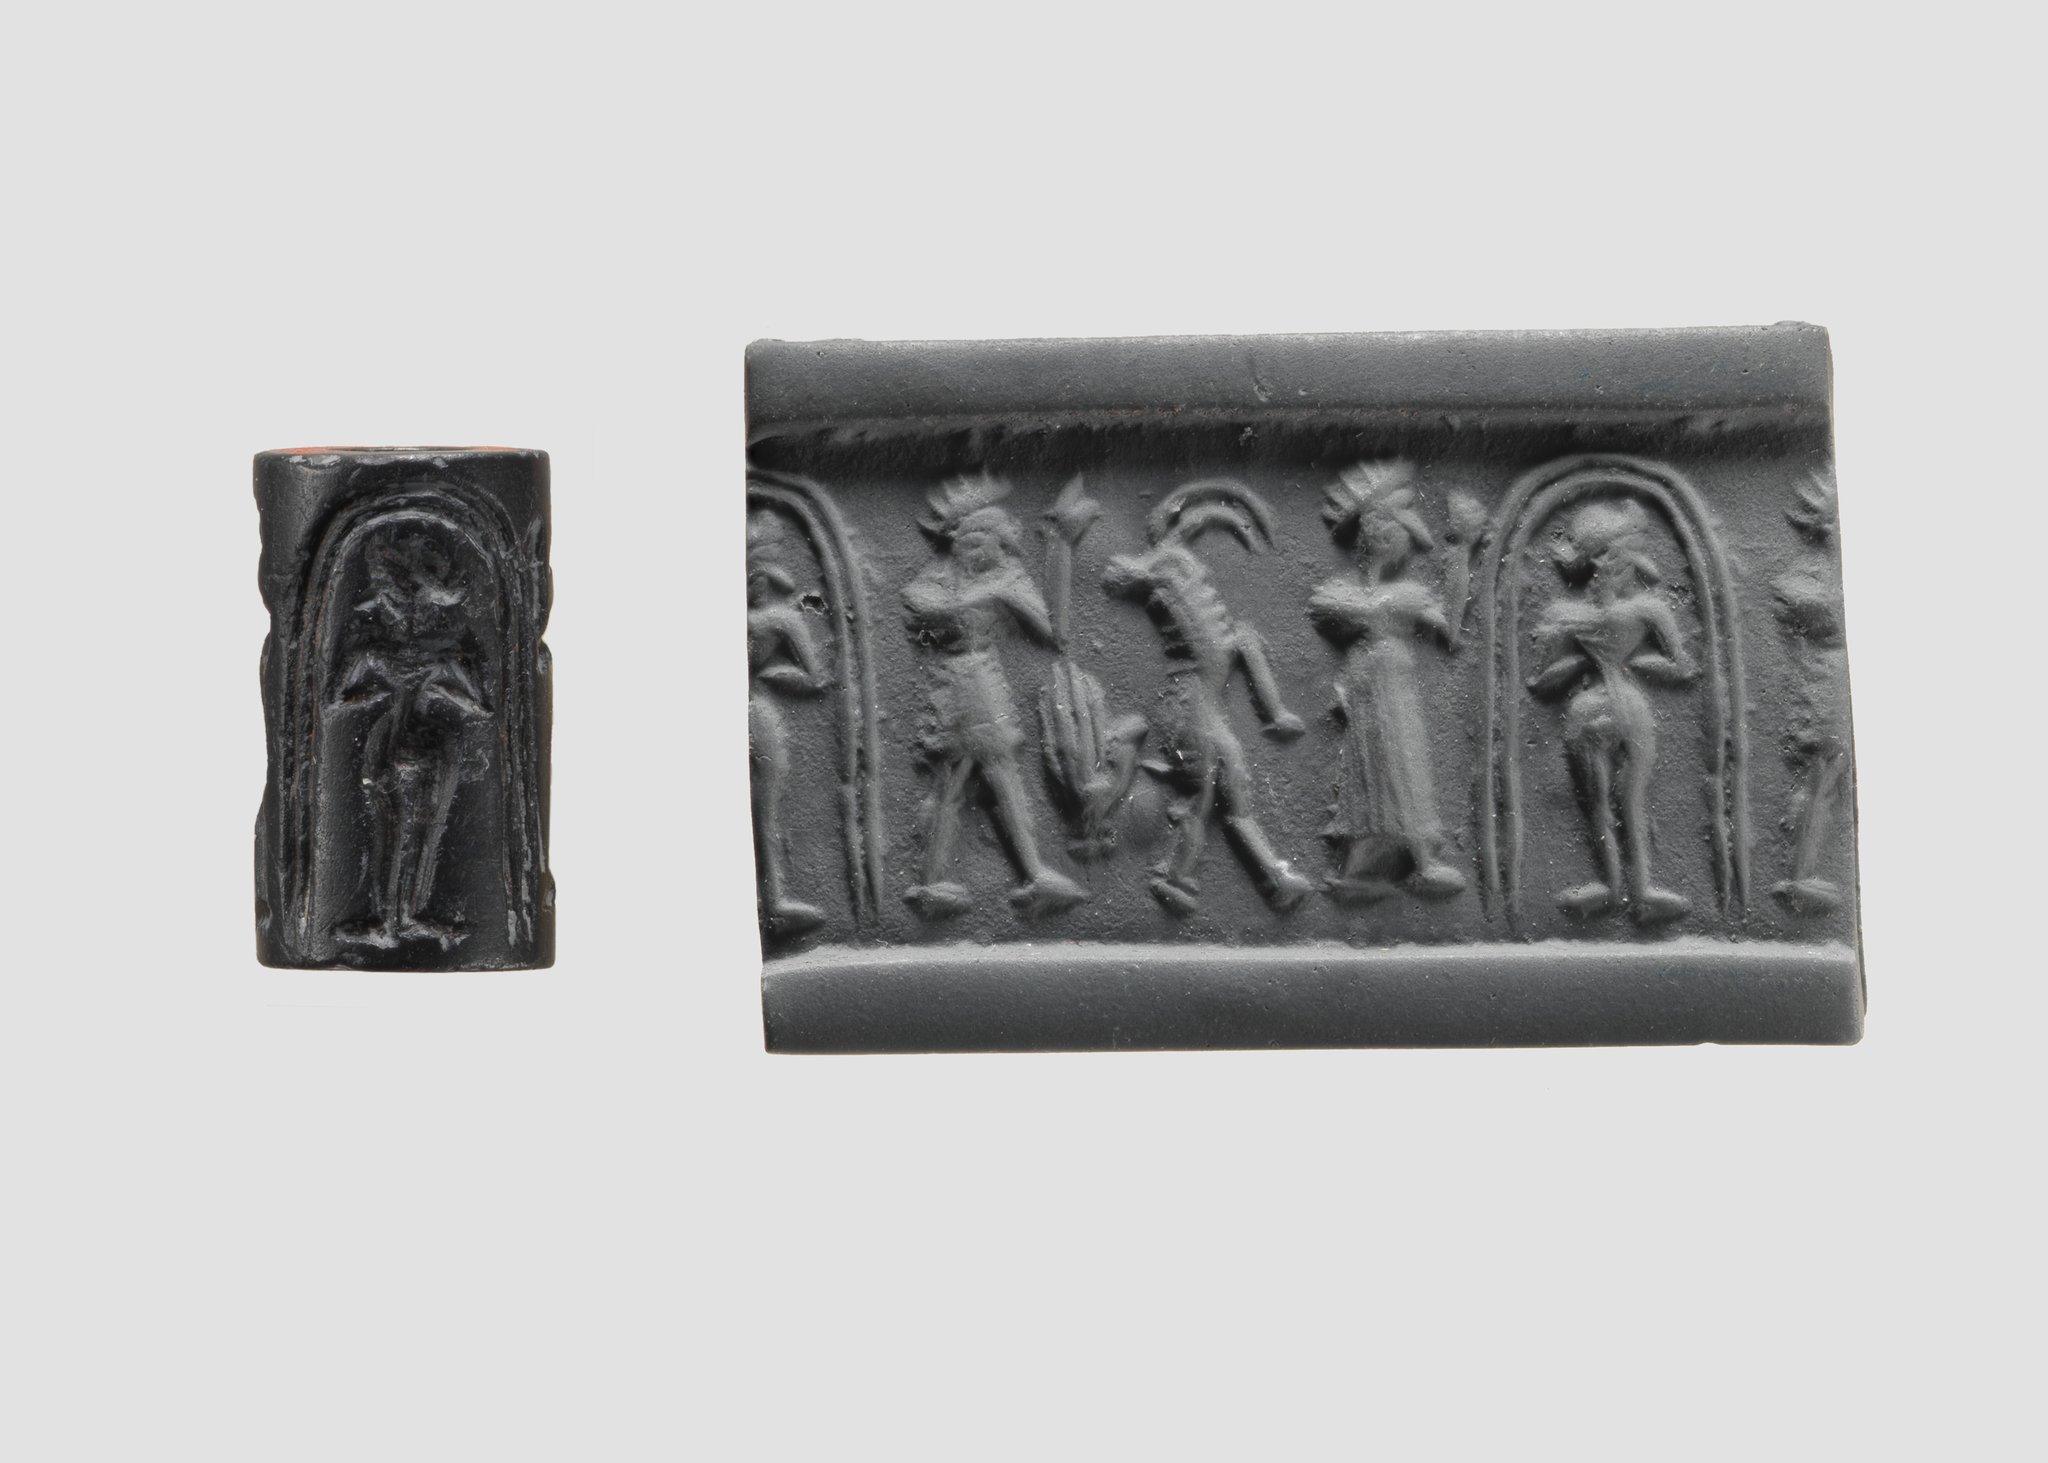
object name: cylinder seal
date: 1820-1730 BCE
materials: mineral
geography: syria